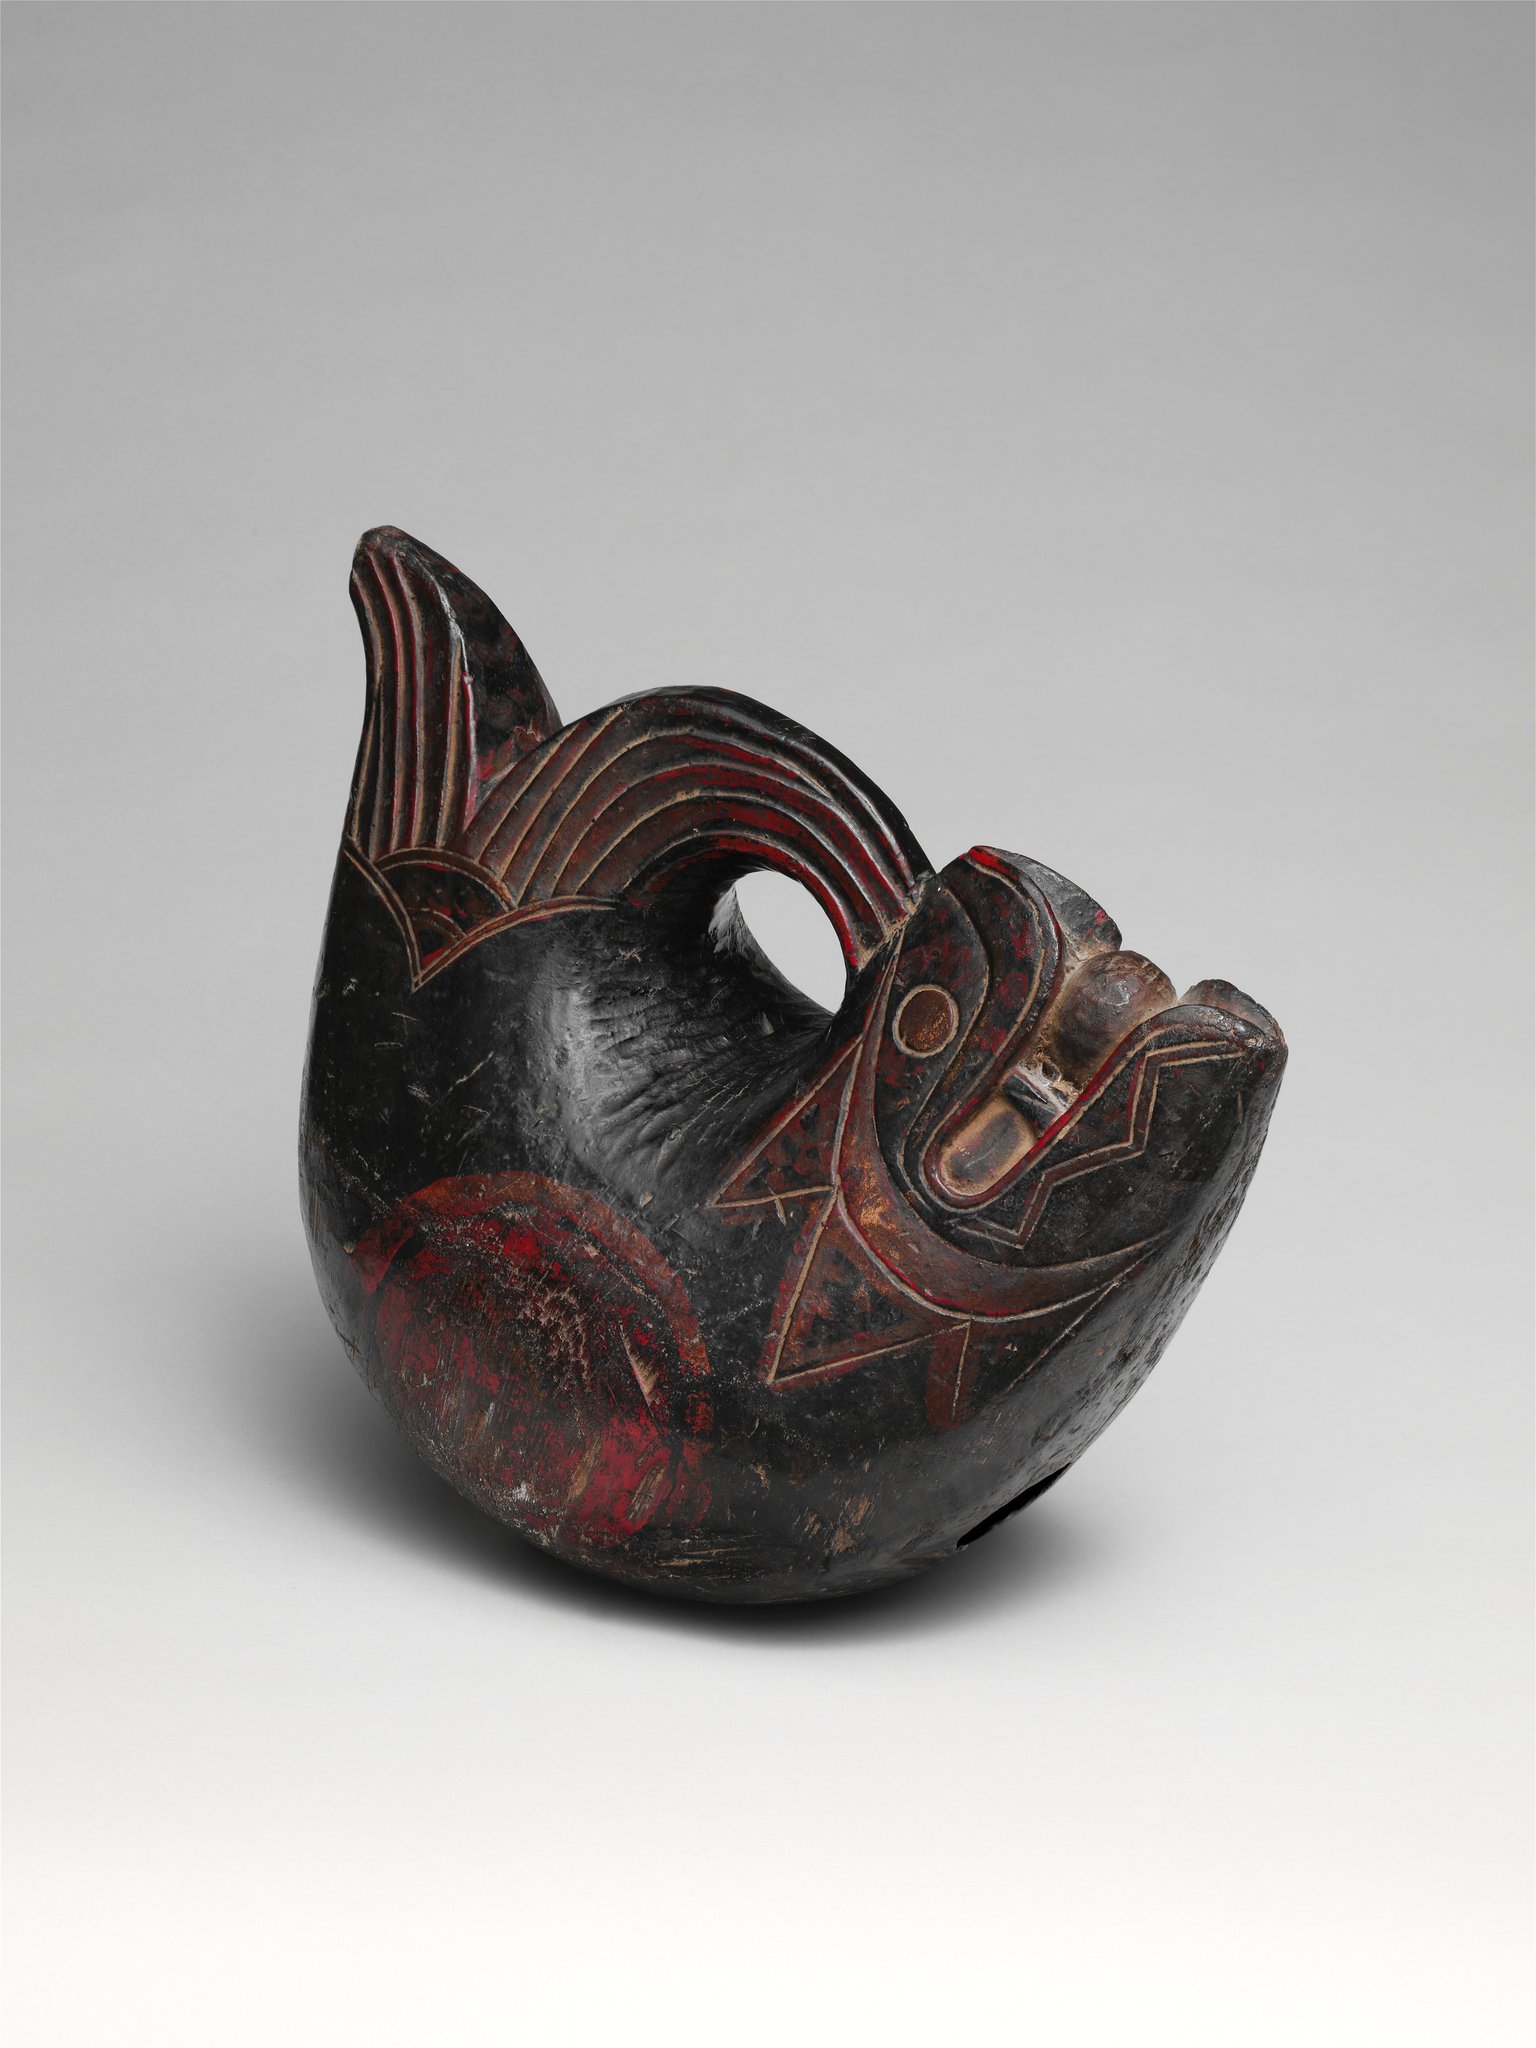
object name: mu yu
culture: chinese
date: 1901-1933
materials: wood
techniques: polychrome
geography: china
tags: fish